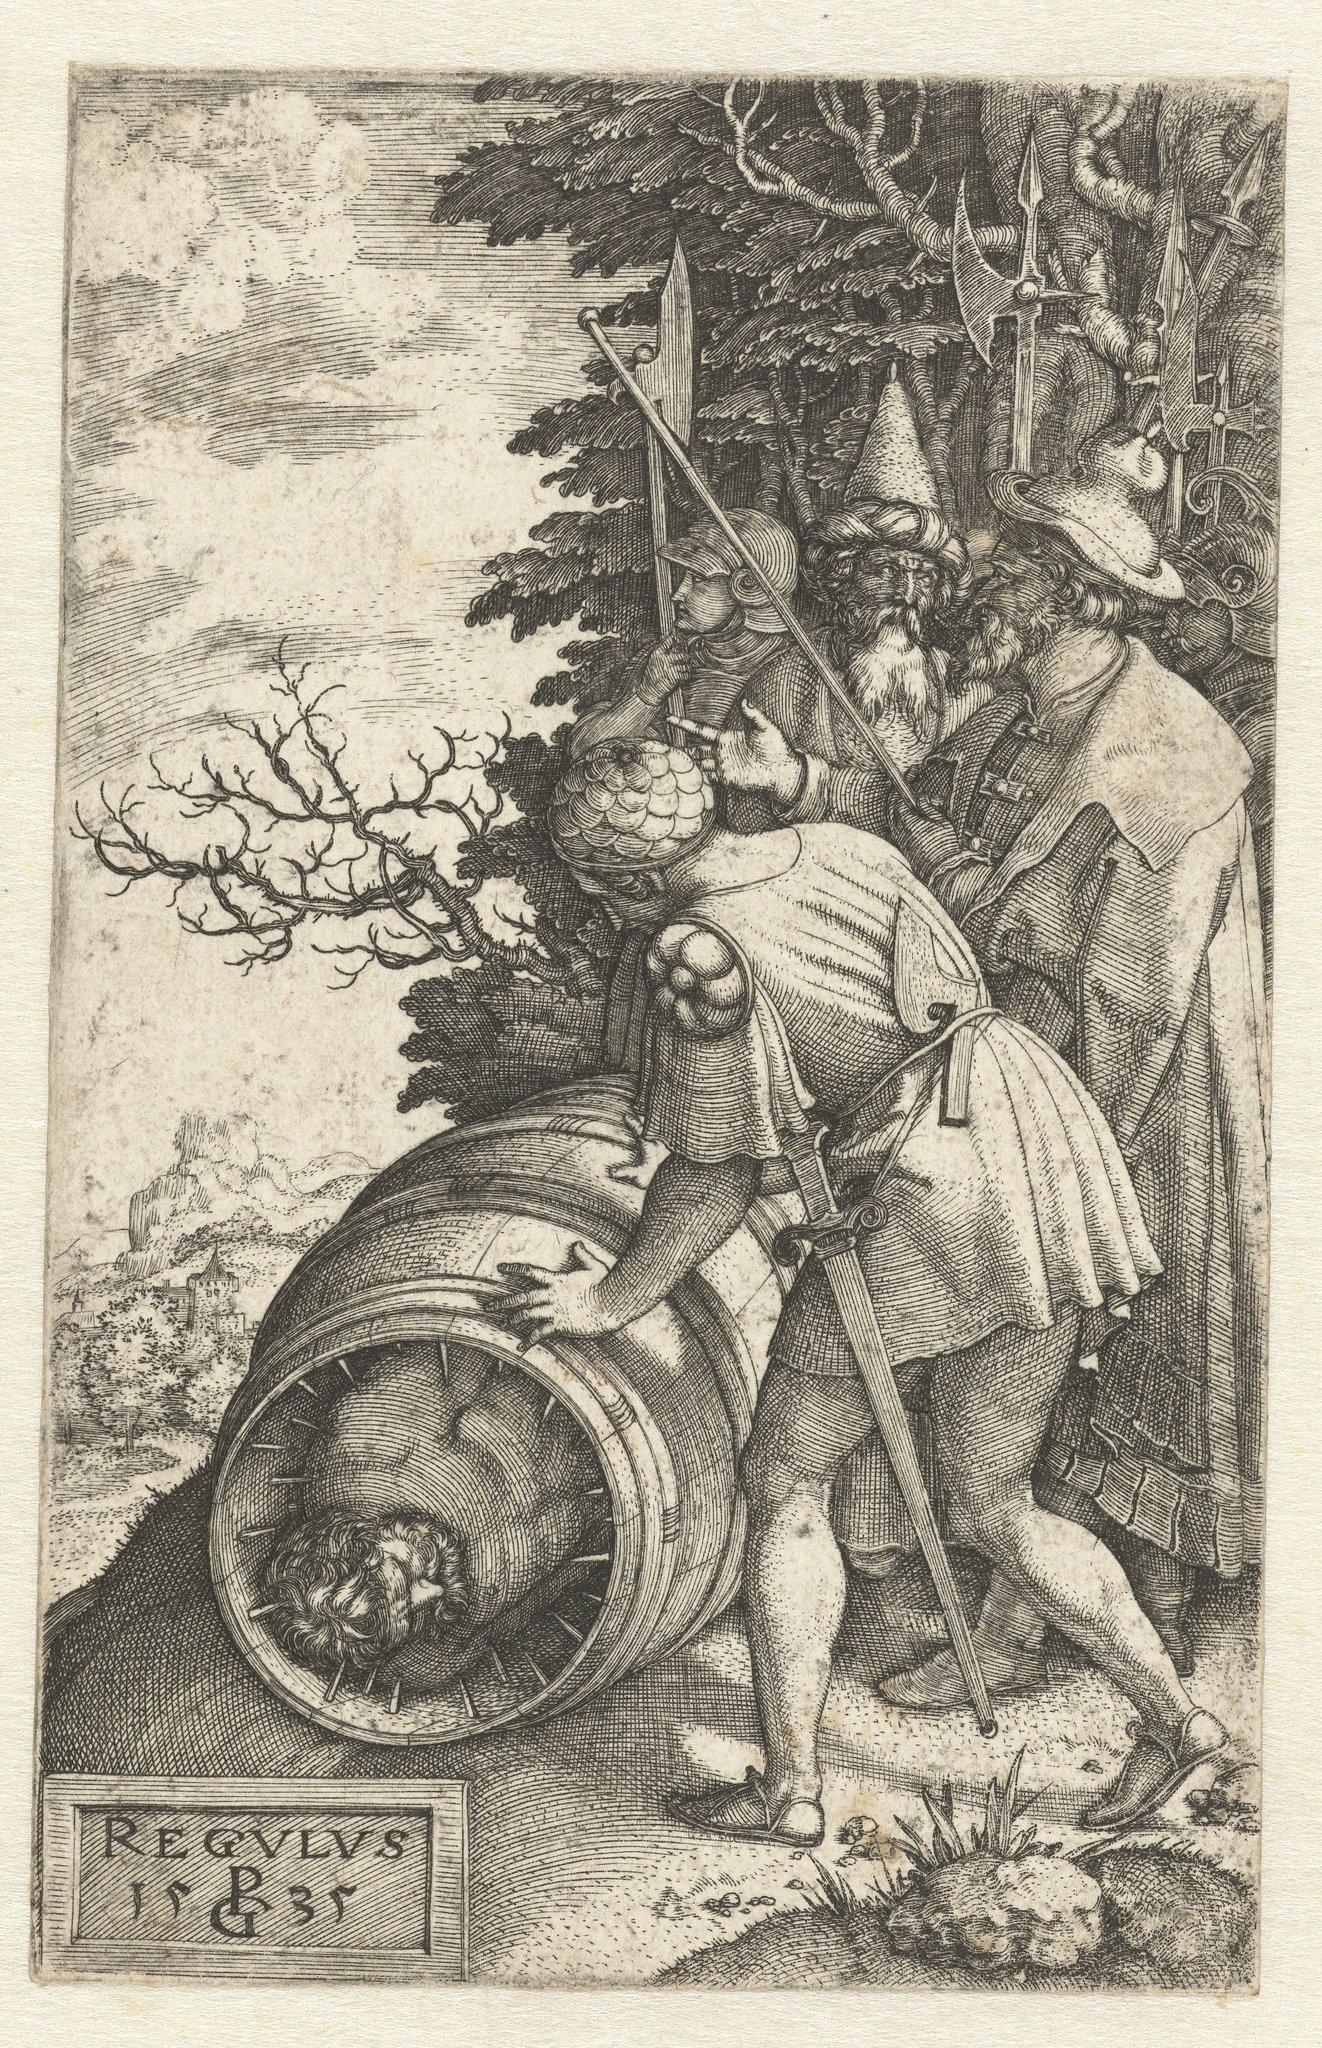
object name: print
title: Regvlvs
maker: georg pencz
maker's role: draughtsman, painter, print maker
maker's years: 1500-1550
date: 1535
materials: paper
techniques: engraving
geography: germany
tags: death of regulus: he is enclosed in a nail-studded barrel by the carthaginians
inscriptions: collector's mark: Lugt 240